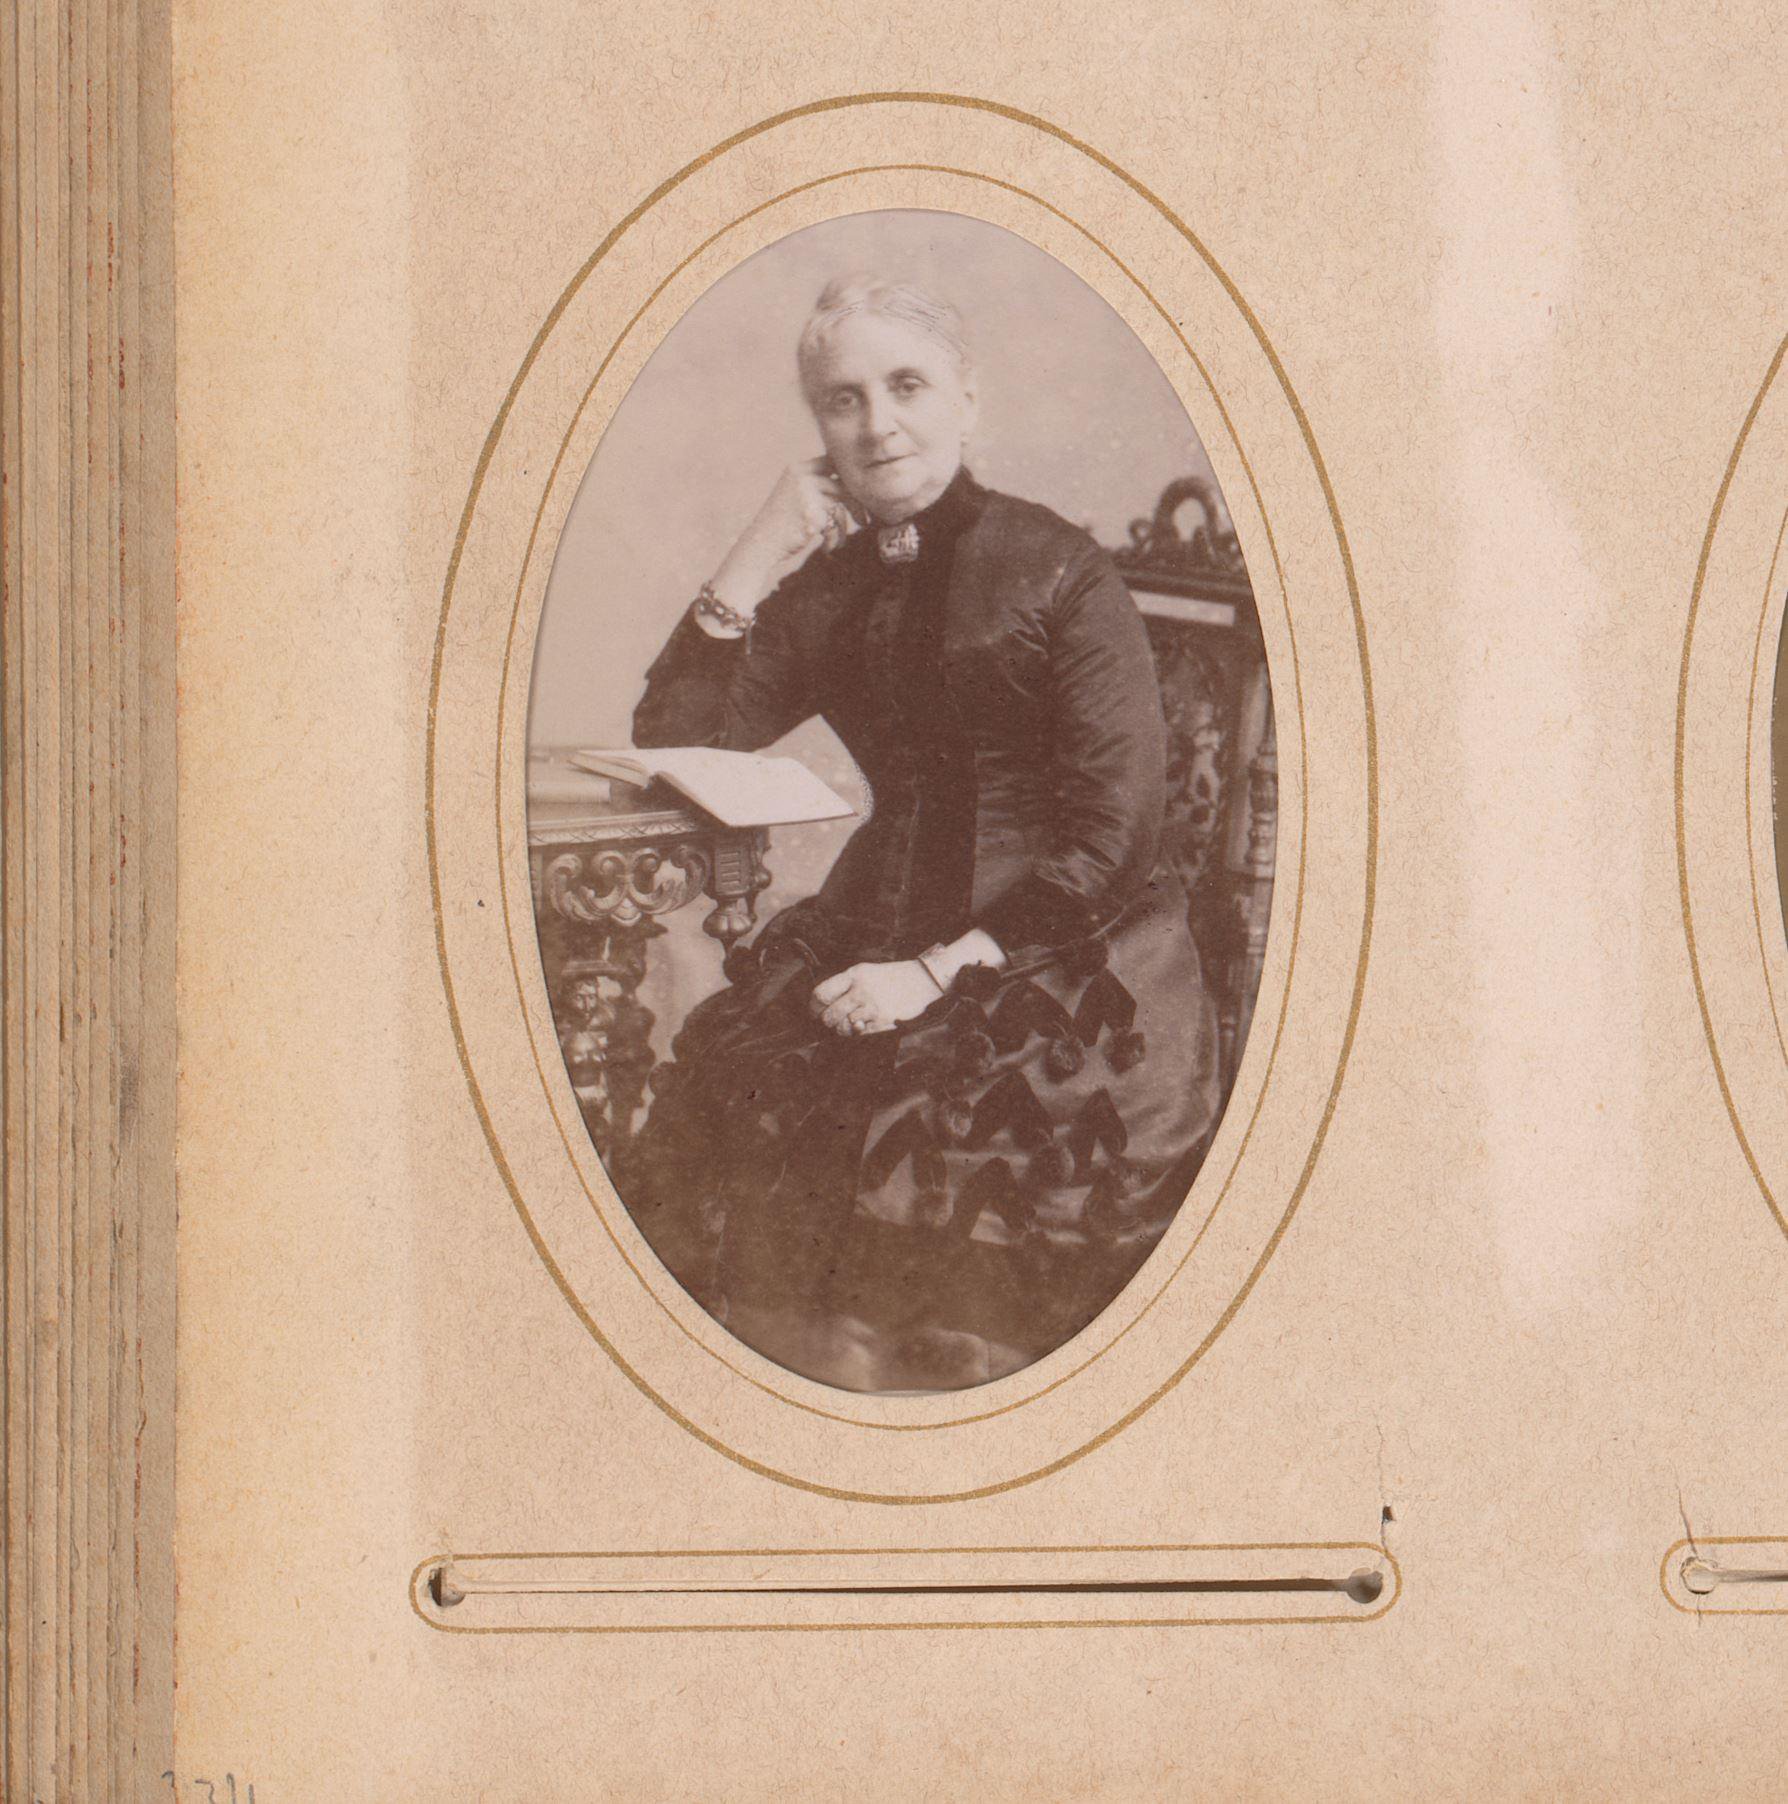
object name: album leaf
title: Portret van een vrouw, zittend aan een tafel met boek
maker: wilhelm ivens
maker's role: fotograaf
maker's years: 1849-1904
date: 1867-1904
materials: cardboard, photographic support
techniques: albumen print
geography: nijmegen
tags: sitting figure - aa - female human figure, historical persons - bb - woman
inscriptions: inscription: ‘Wilh. Ivens/ Nymegen/ 20, Houtstraat 20’